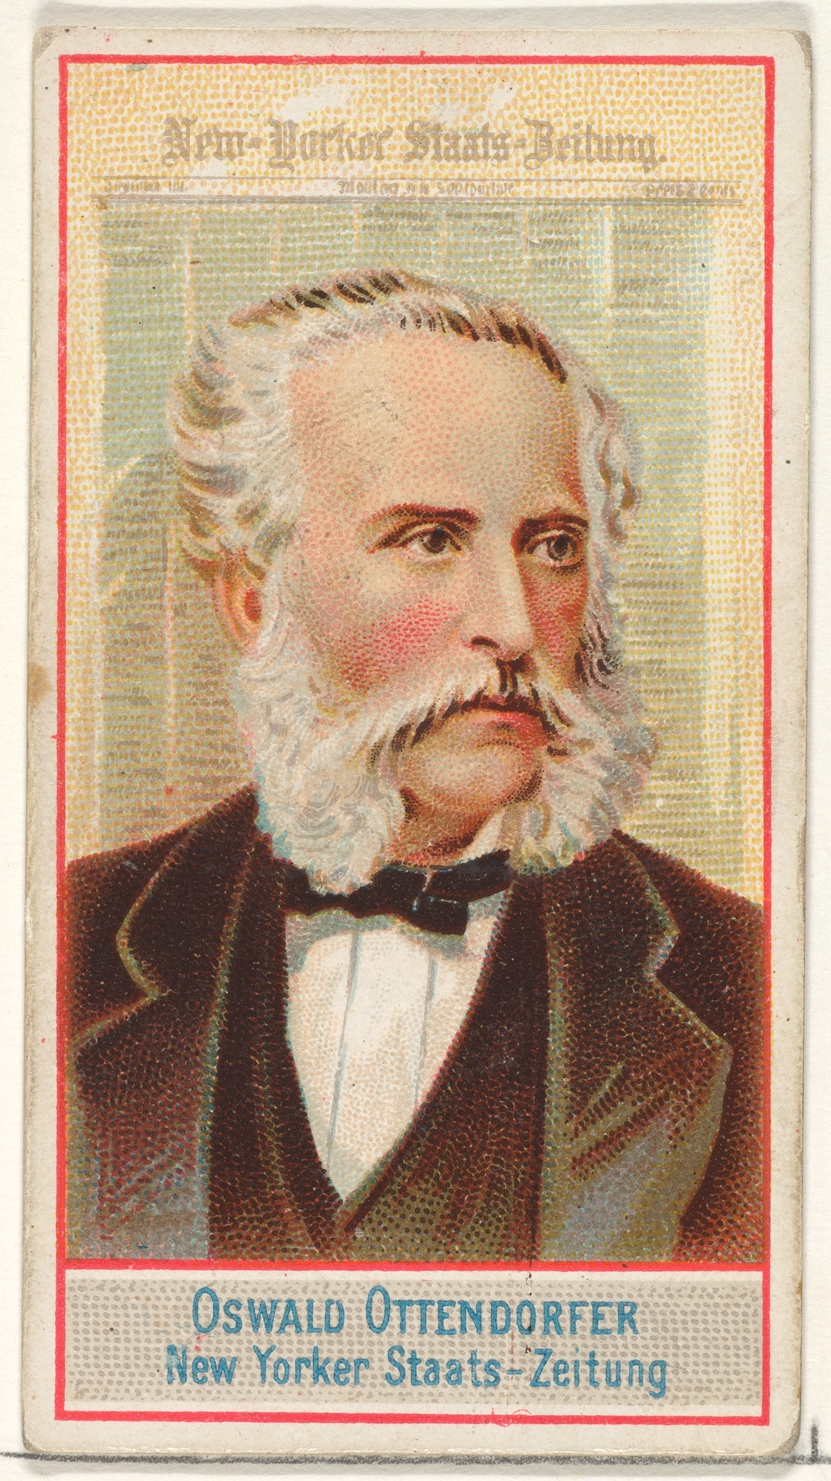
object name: print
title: Oswald Ottendorfer, New Yorker Staats-Zeitung, from the American Editors series (N1) for Allen & Ginter Cigarettes Brands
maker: allen & ginter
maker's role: publisher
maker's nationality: american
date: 1887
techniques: color lithograph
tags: men,portraits